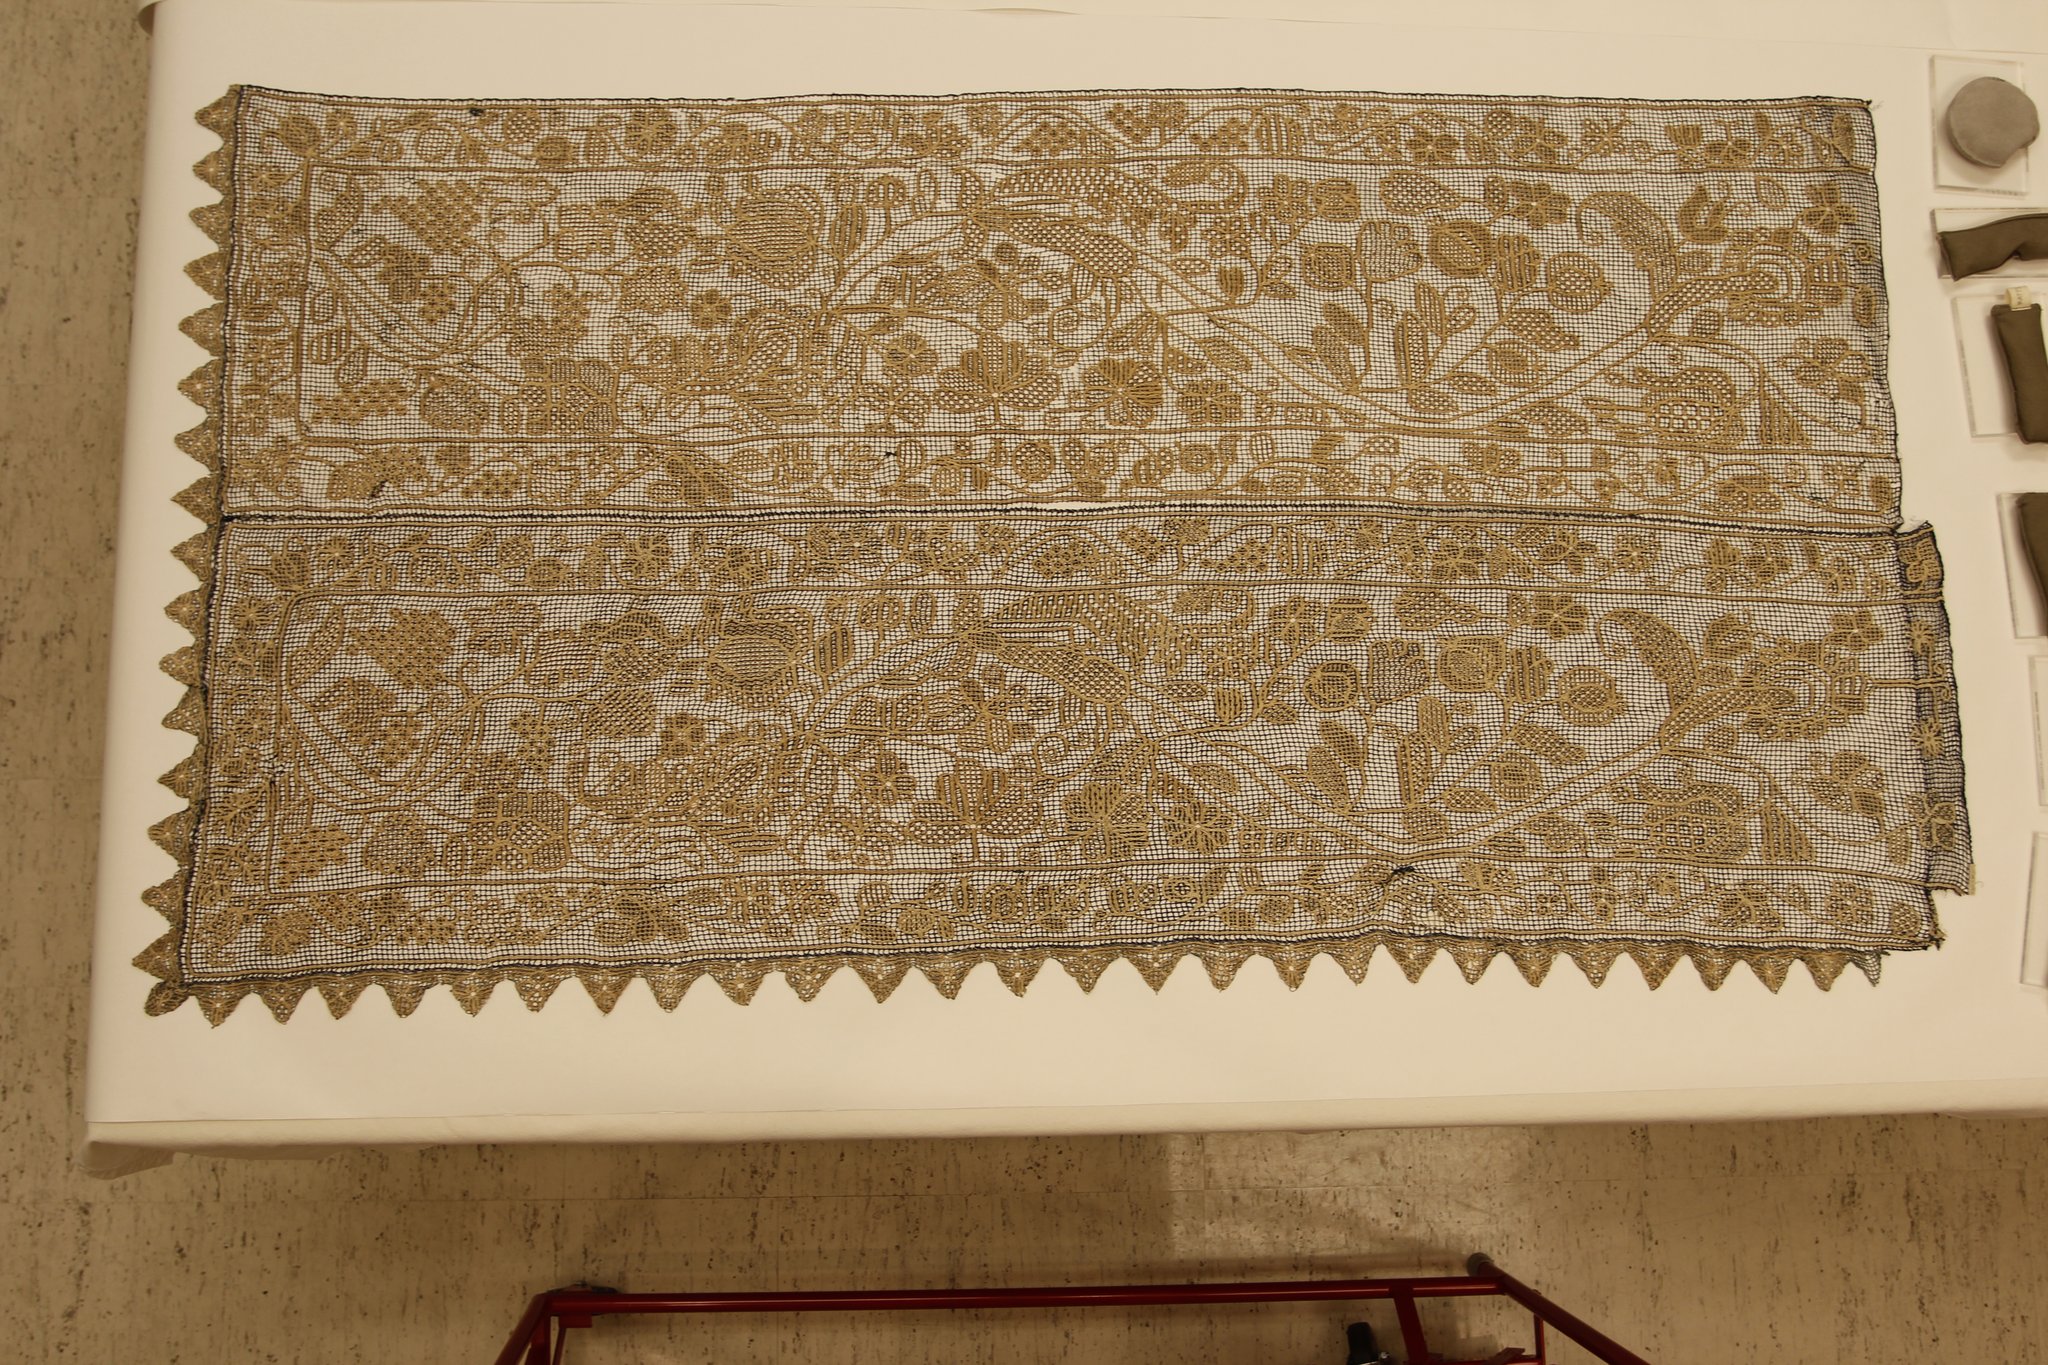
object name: curtain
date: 1601-1633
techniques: embroidery